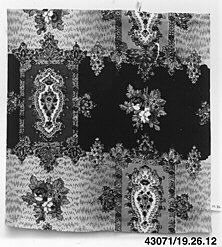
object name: sample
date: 1840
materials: cotton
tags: flowers